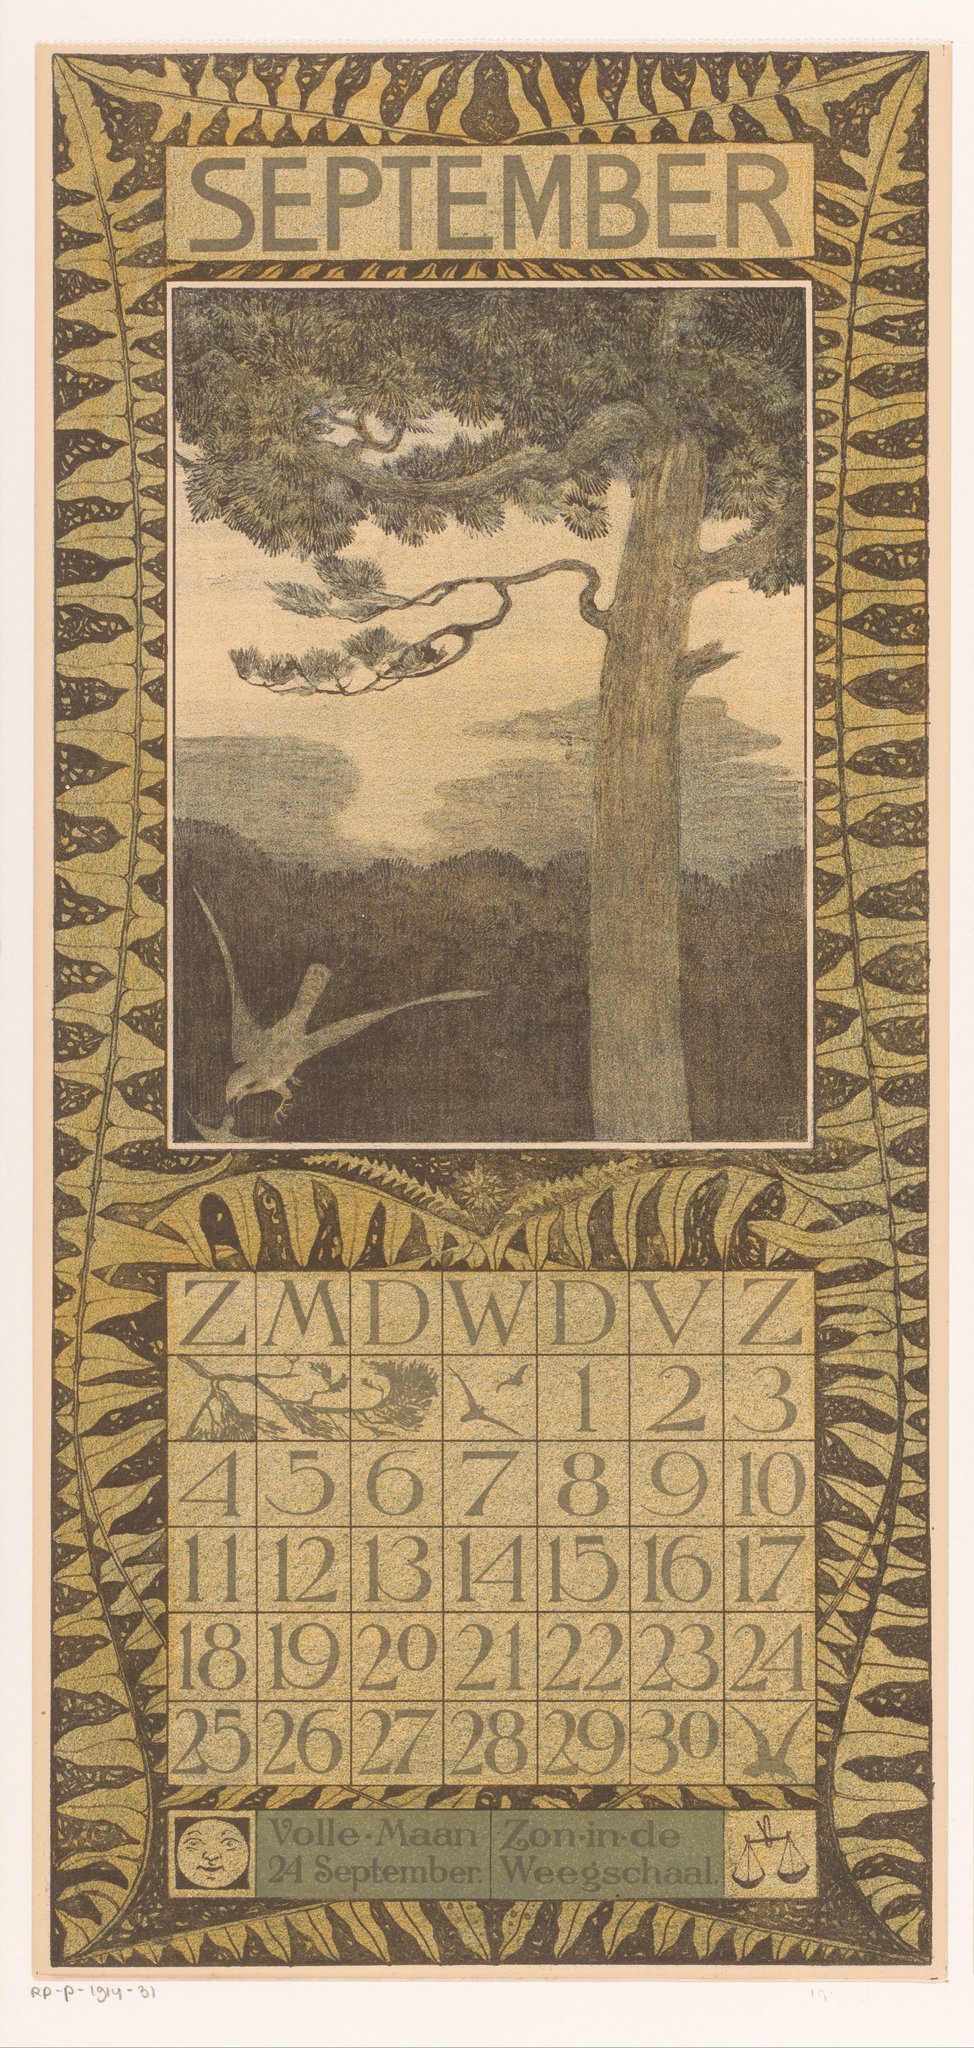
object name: calendar leaf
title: Kalenderblad september met boom en valk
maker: theo van hoytema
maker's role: draughtsman, painter, print maker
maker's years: 1863-1917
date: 1903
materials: paper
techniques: lithograph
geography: amsterdam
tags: predatory birds: falcon, full moon represented as face, libra (zodiacal sign of september), september ~ other concepts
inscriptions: collector's mark: Lugt 2228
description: De valk duikt naar beneden achter een prooi aan. Onder de data een volle maan en het sterrenbeeld Weegschaal. Bovenaan het blad een scheurlijn.